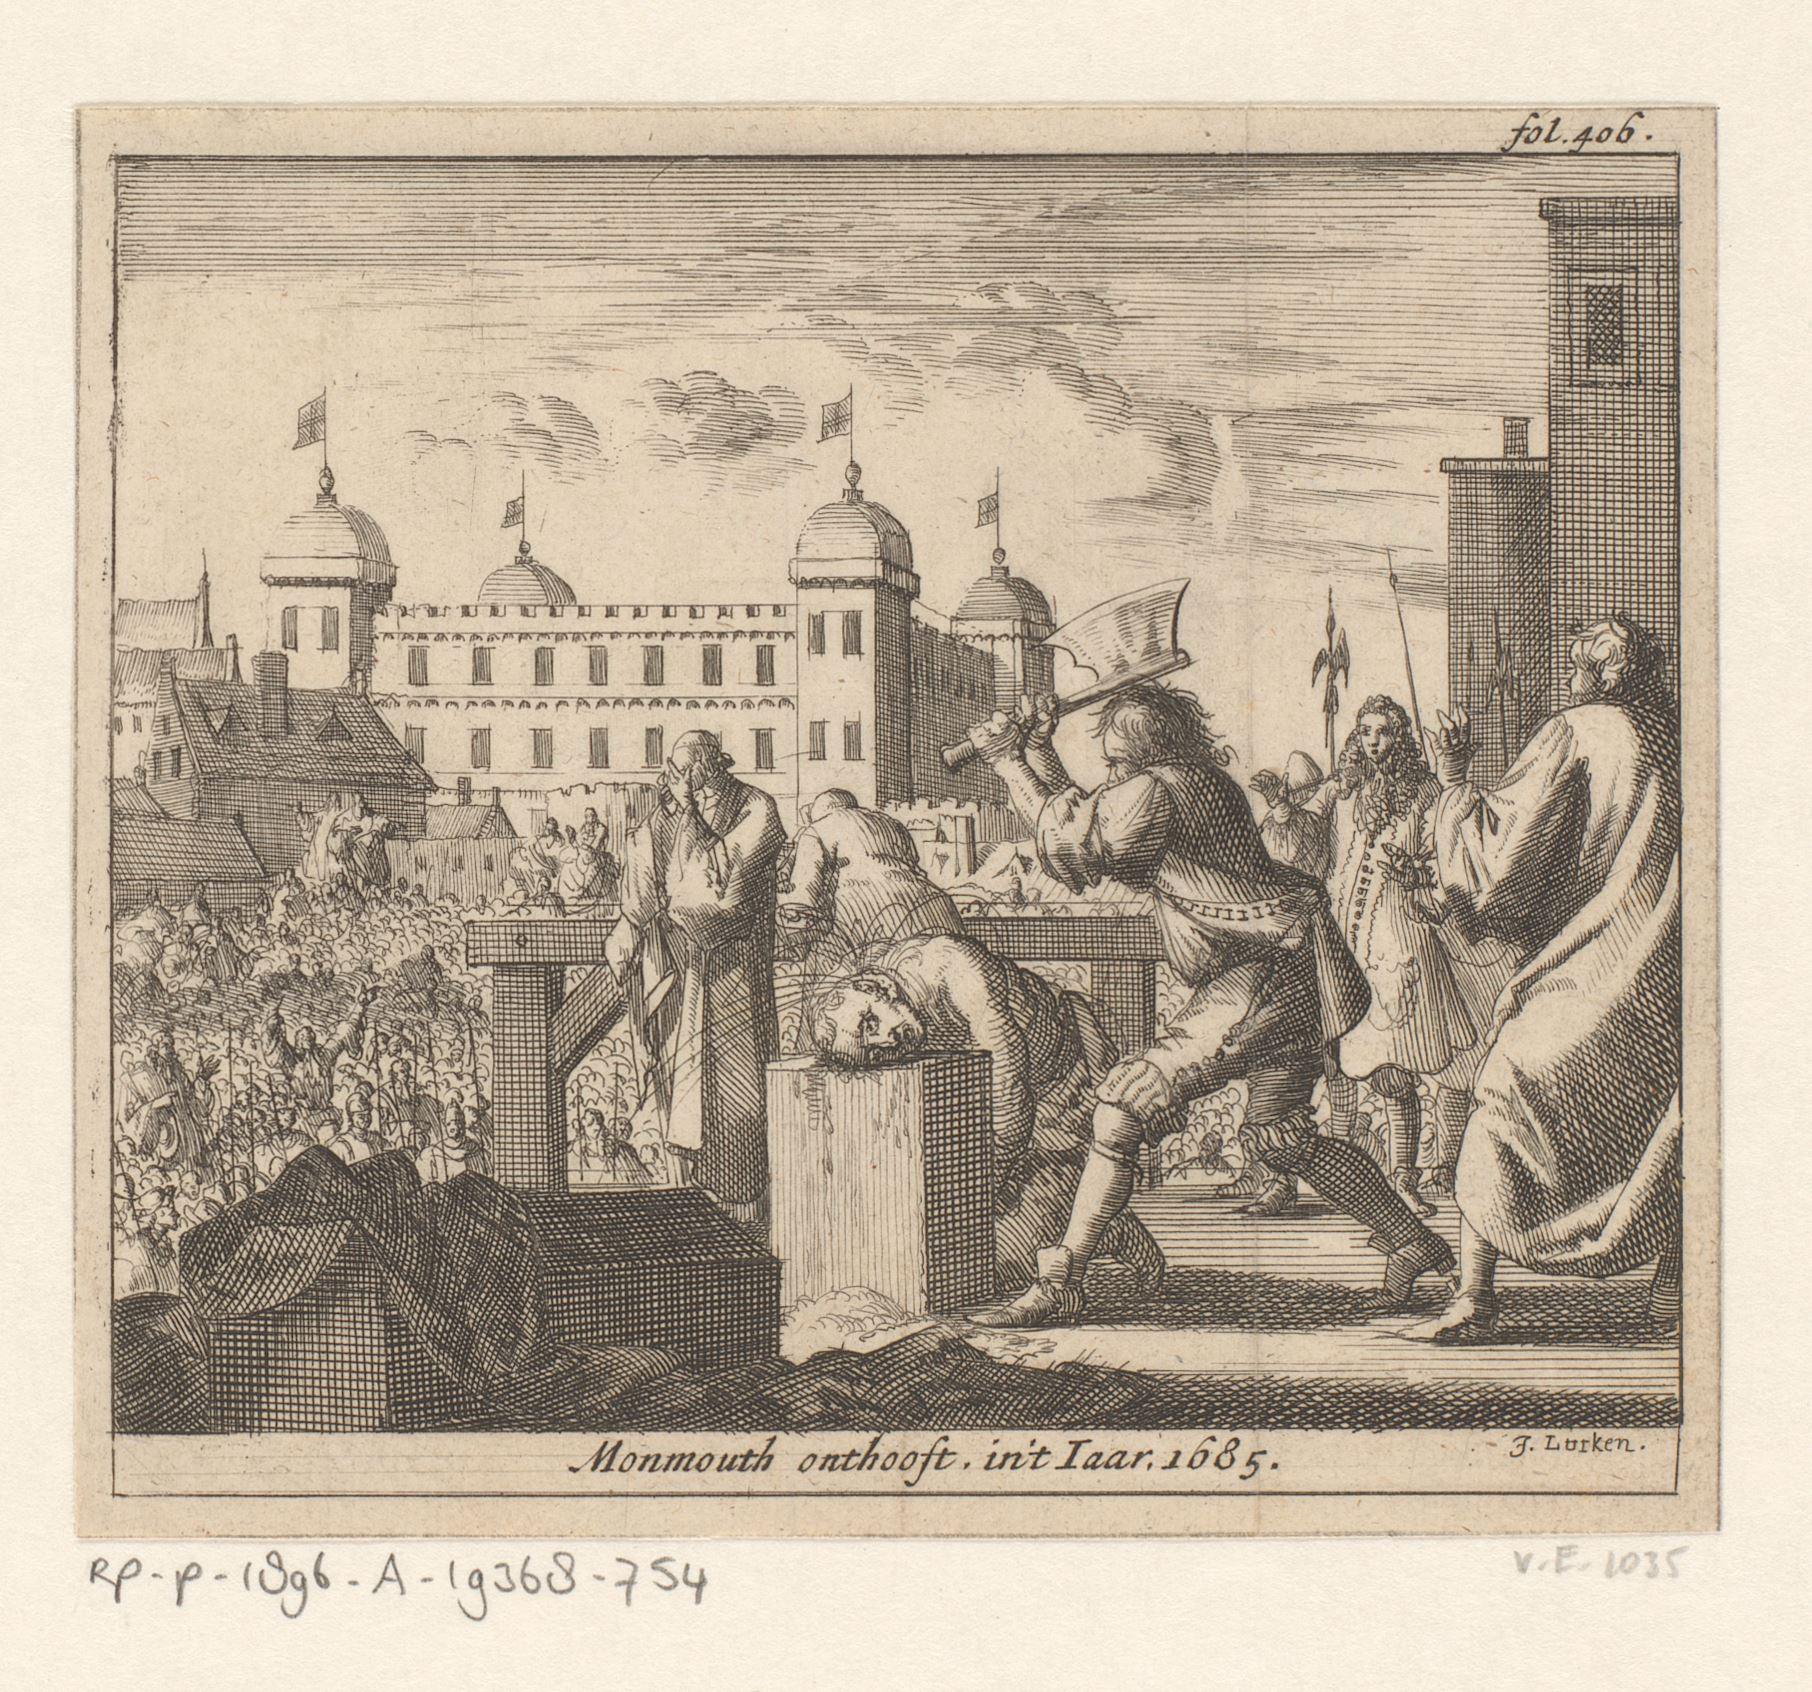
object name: book illustration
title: Monmouth onthoofd in 't Jaar 1685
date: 1689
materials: paper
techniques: etching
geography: utrecht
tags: rotterdam, london, violent death by beheading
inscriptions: collector's mark: Lugt 2228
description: Illustratie uit: Pers, Dirck Pietersz. Romeynschen adelaer, waer in de loffelĳcke en lasterlĳcke daden der Romeynsche koningen, en keyseren, verhandelt werden, 3 delen. Utrecht: Jurriaen van Poolsum, 1689, fol. 406.